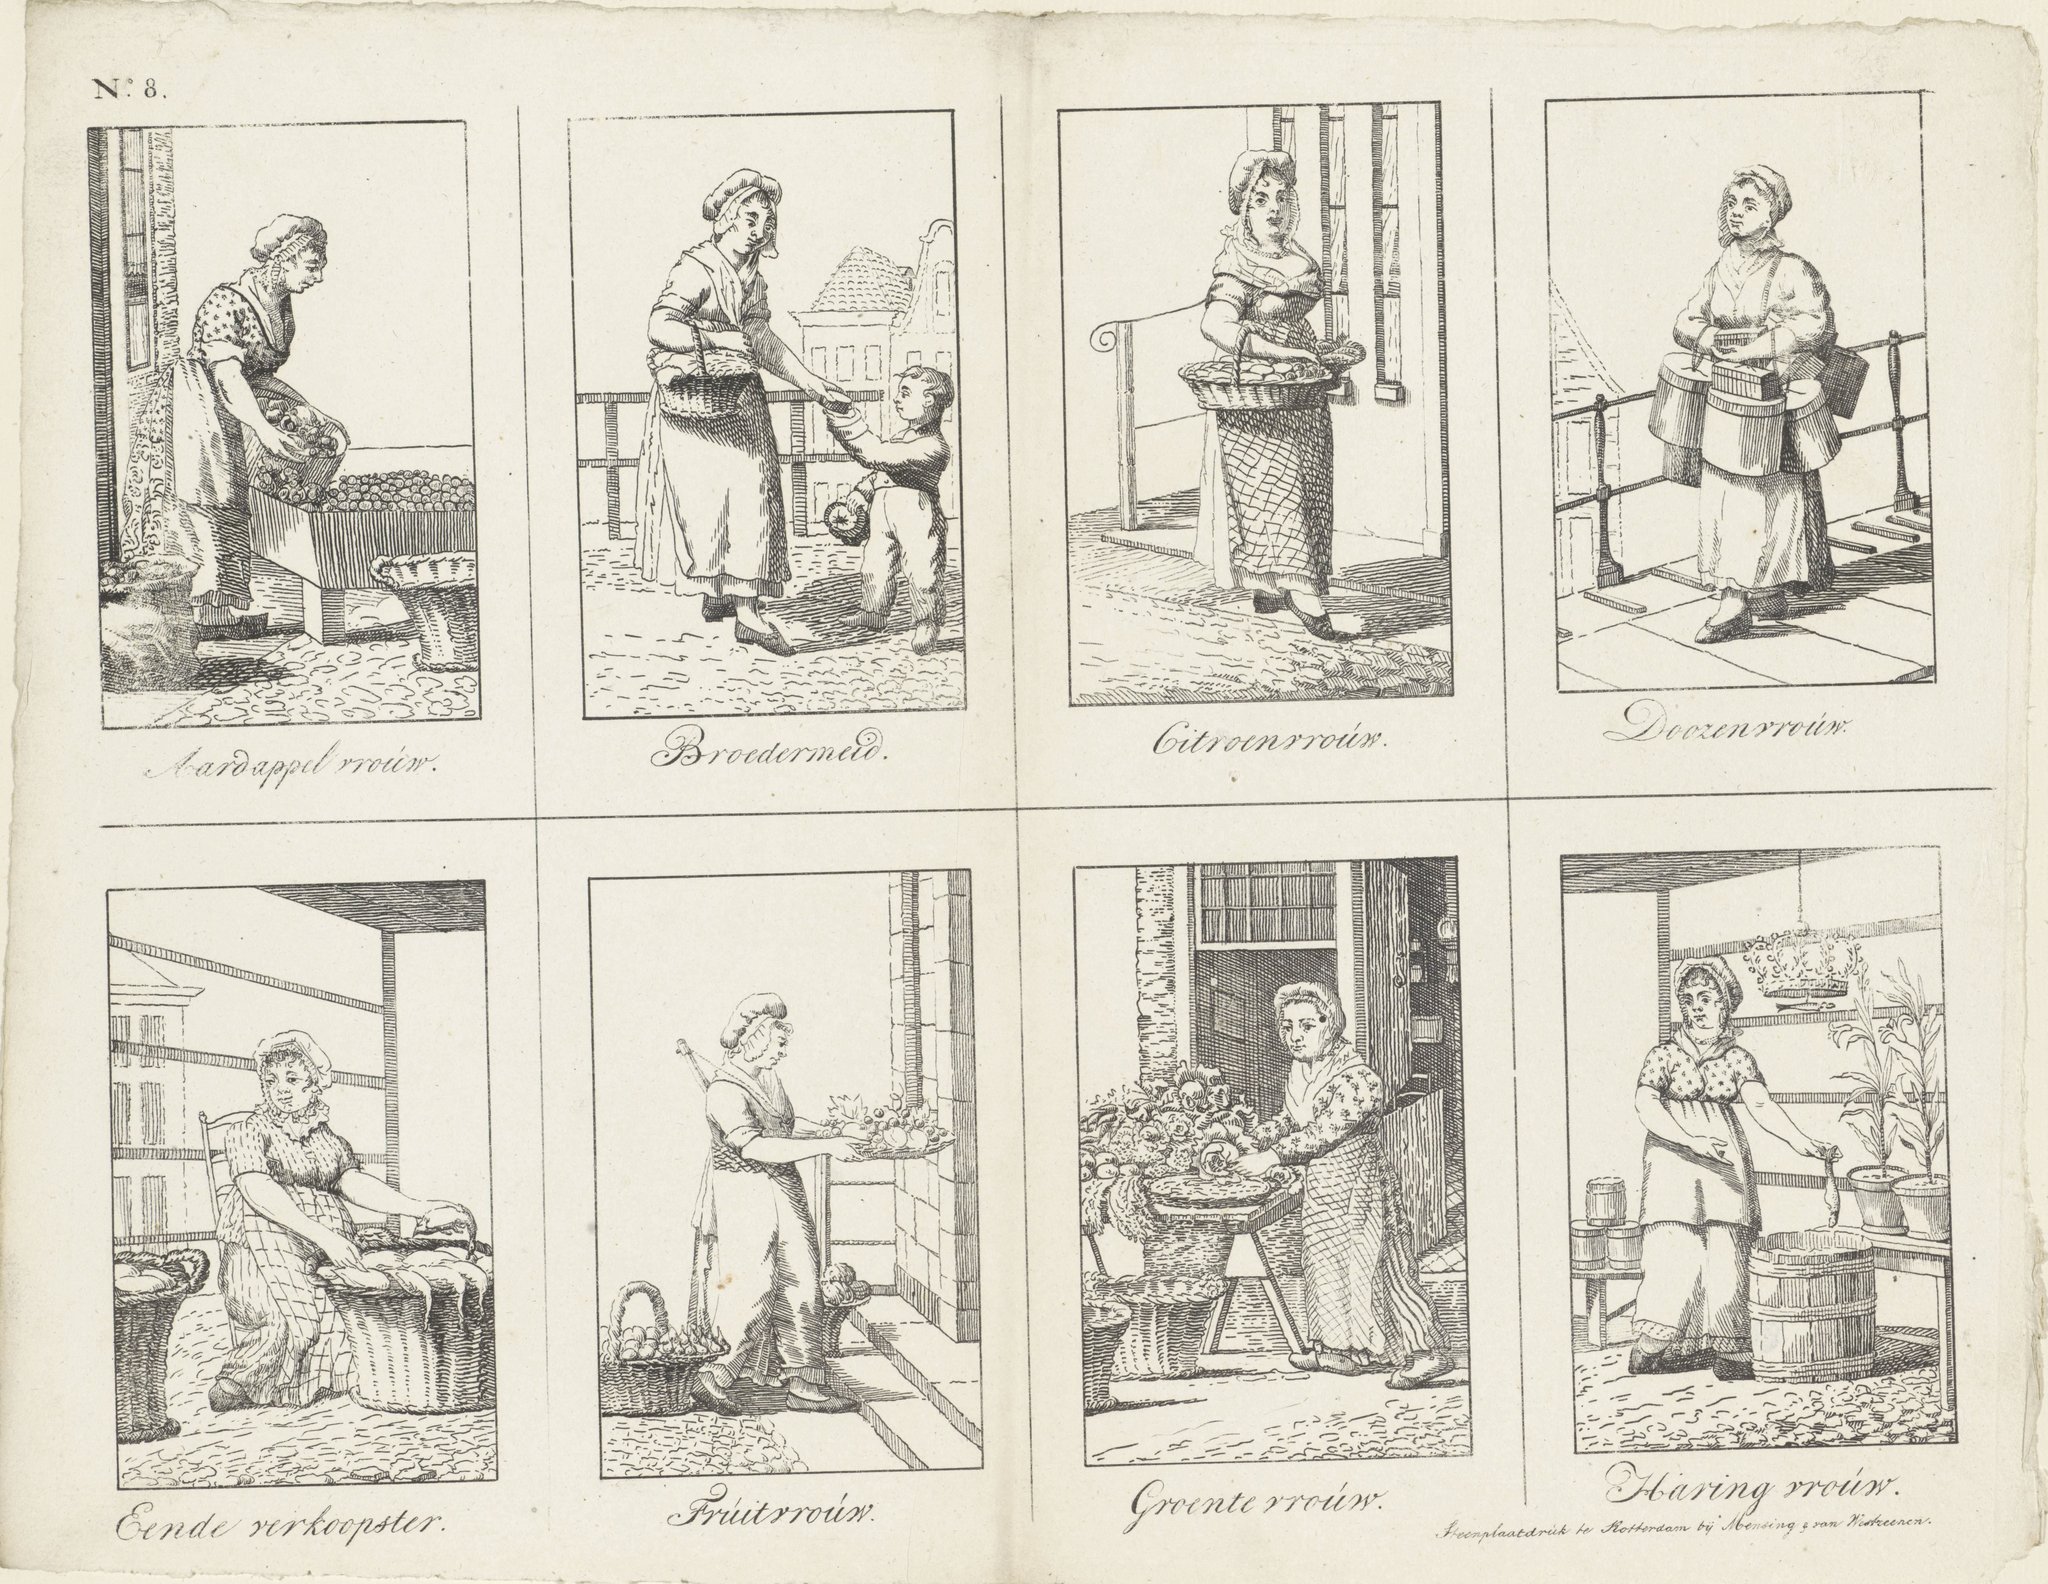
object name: popular print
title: beroepen alfabet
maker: Anonymous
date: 1825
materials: paper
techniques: lithograph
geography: rotterdam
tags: craft-production, skilled handiwork, letters, alphabet, script, street-trader, crafts and industries, merchant, salesman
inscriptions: collector's mark: Lugt 2760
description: Blad met 8 voorstellingen van de letters van het alfabet (A-H) geïllustreerd met vrouwelijke beroepen waarvan de woorden met de betreffende letter beginnen. Onder elke afbeelding een onderschrift. Genummerd linksboven: No. 8.